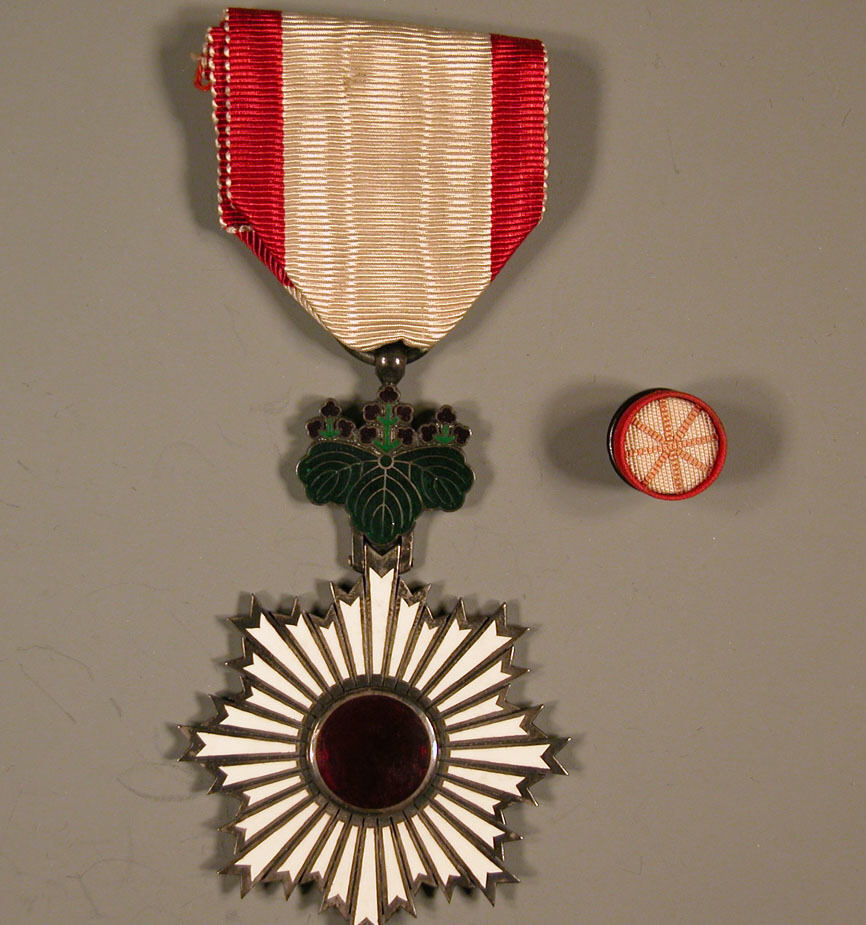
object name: insignia and button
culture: japanese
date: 1867-1900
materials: ribbon